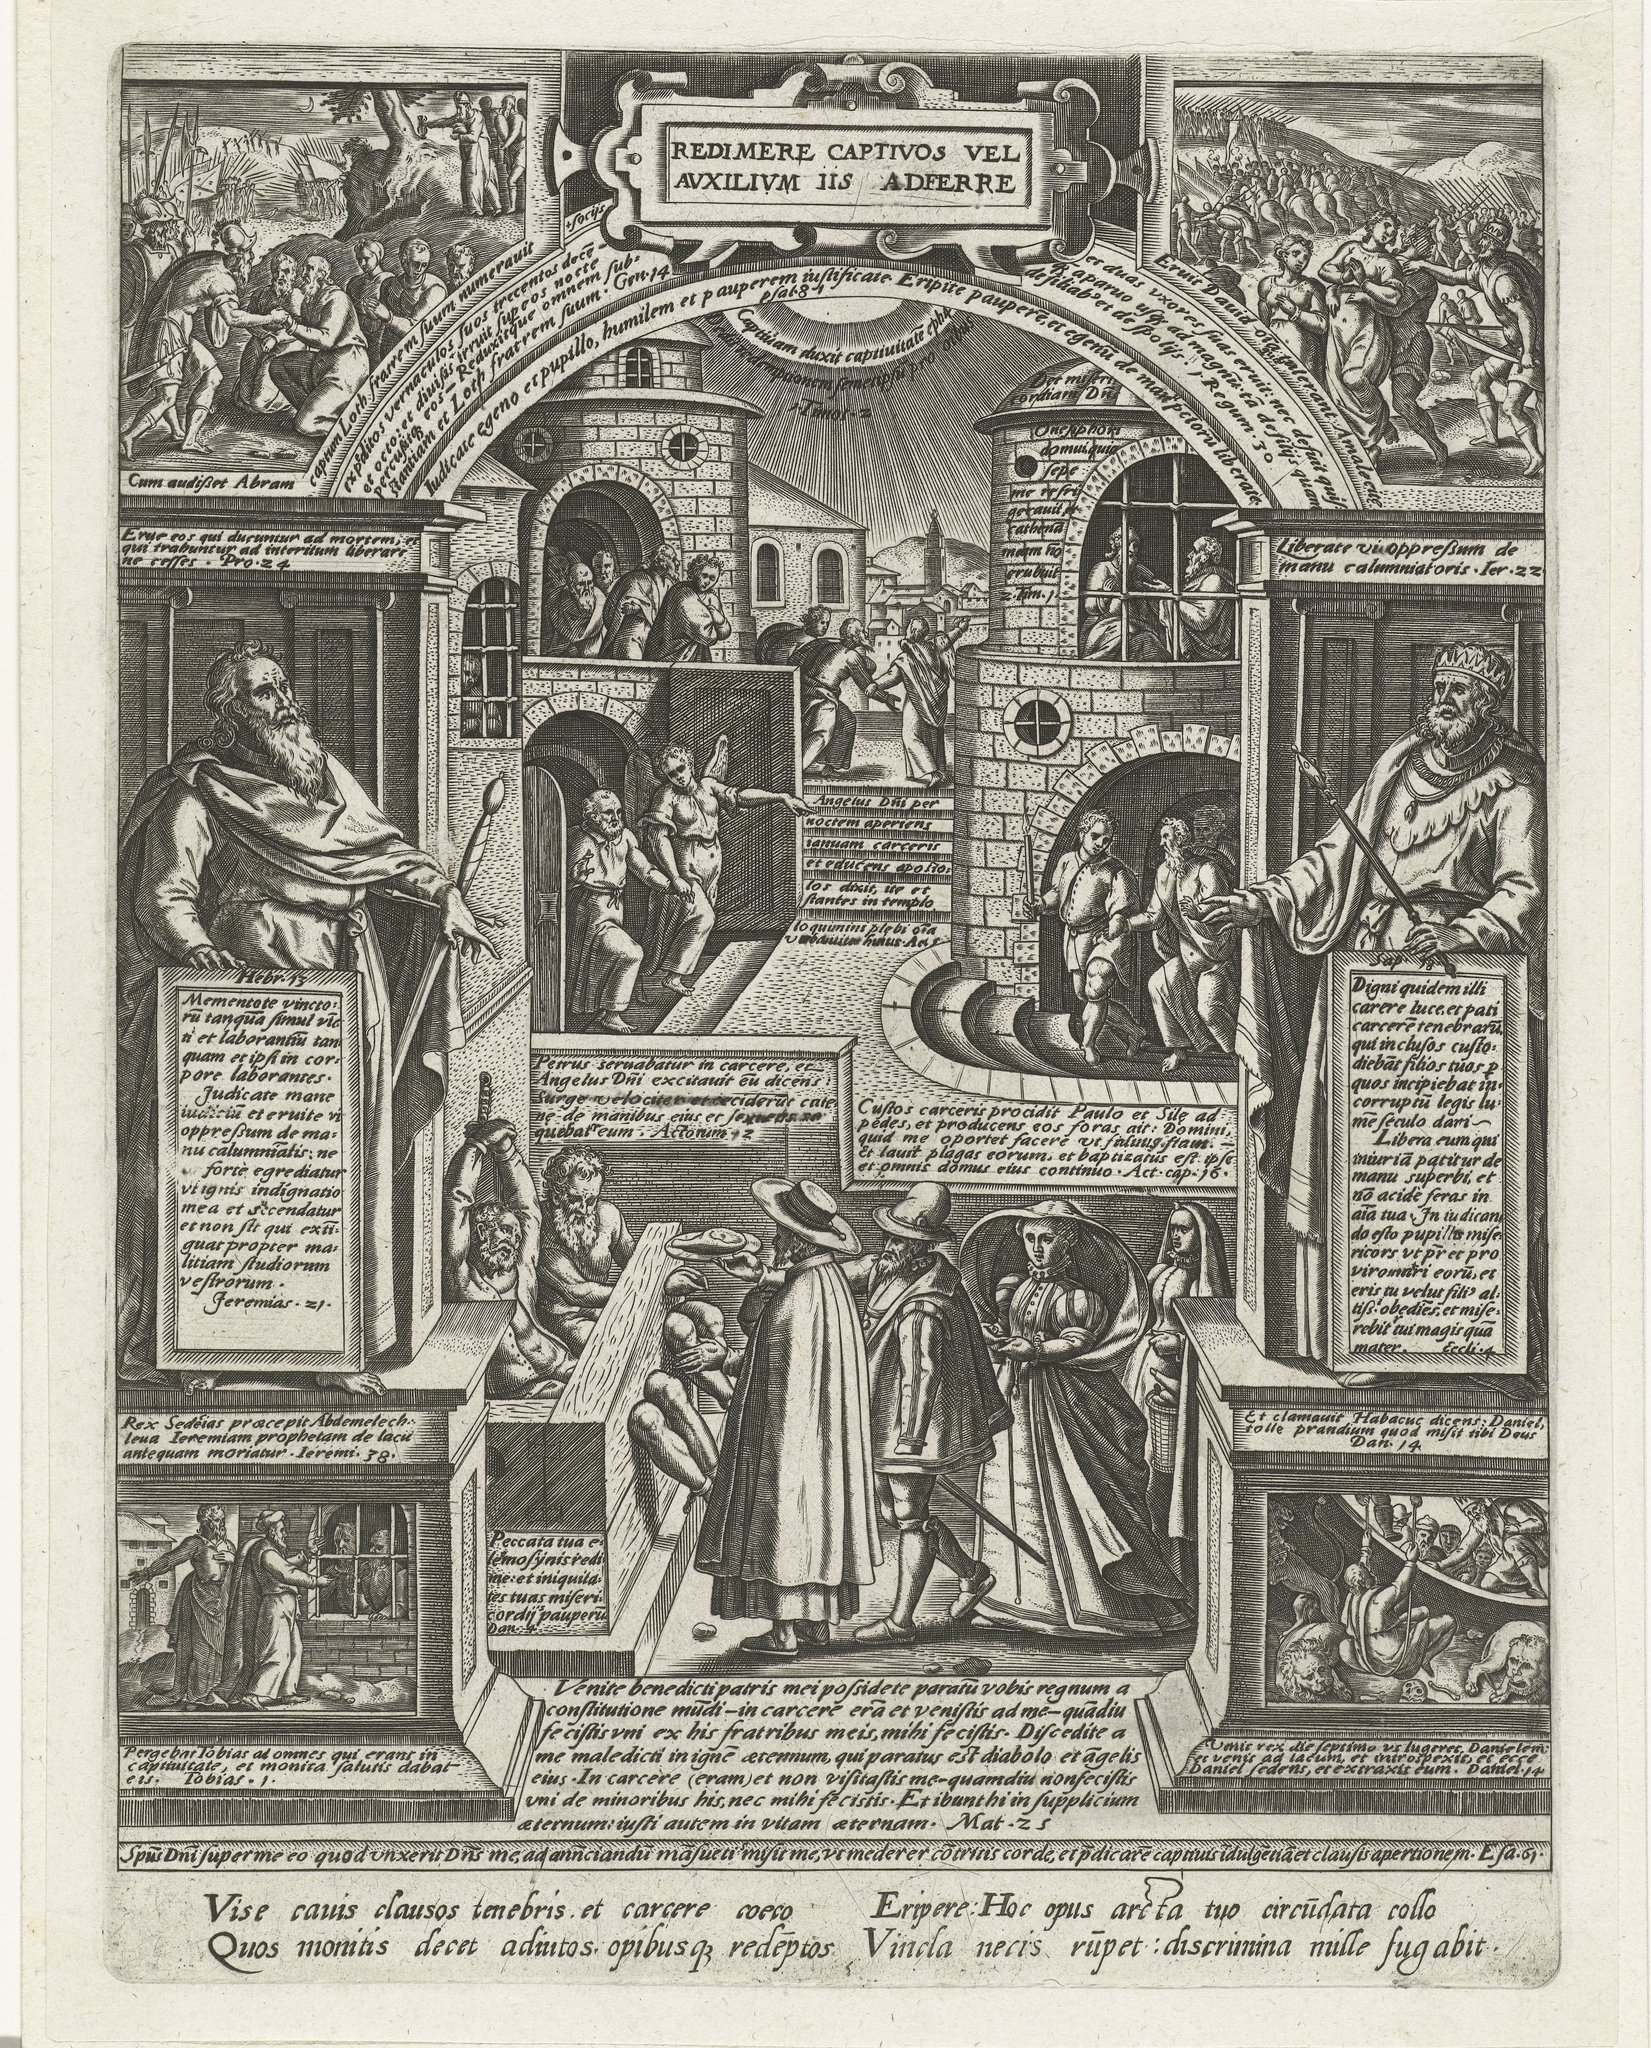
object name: print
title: Redimere captivos vel auxilium iis adferre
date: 1577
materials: paper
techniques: engraving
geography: low countries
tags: visiting or liberating the imprisoned, 'incarceratus solatur' ~ one of the (seven) acts of mercy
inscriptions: collector's mark: Lugt 2228, collector's mark: Lugt 2760